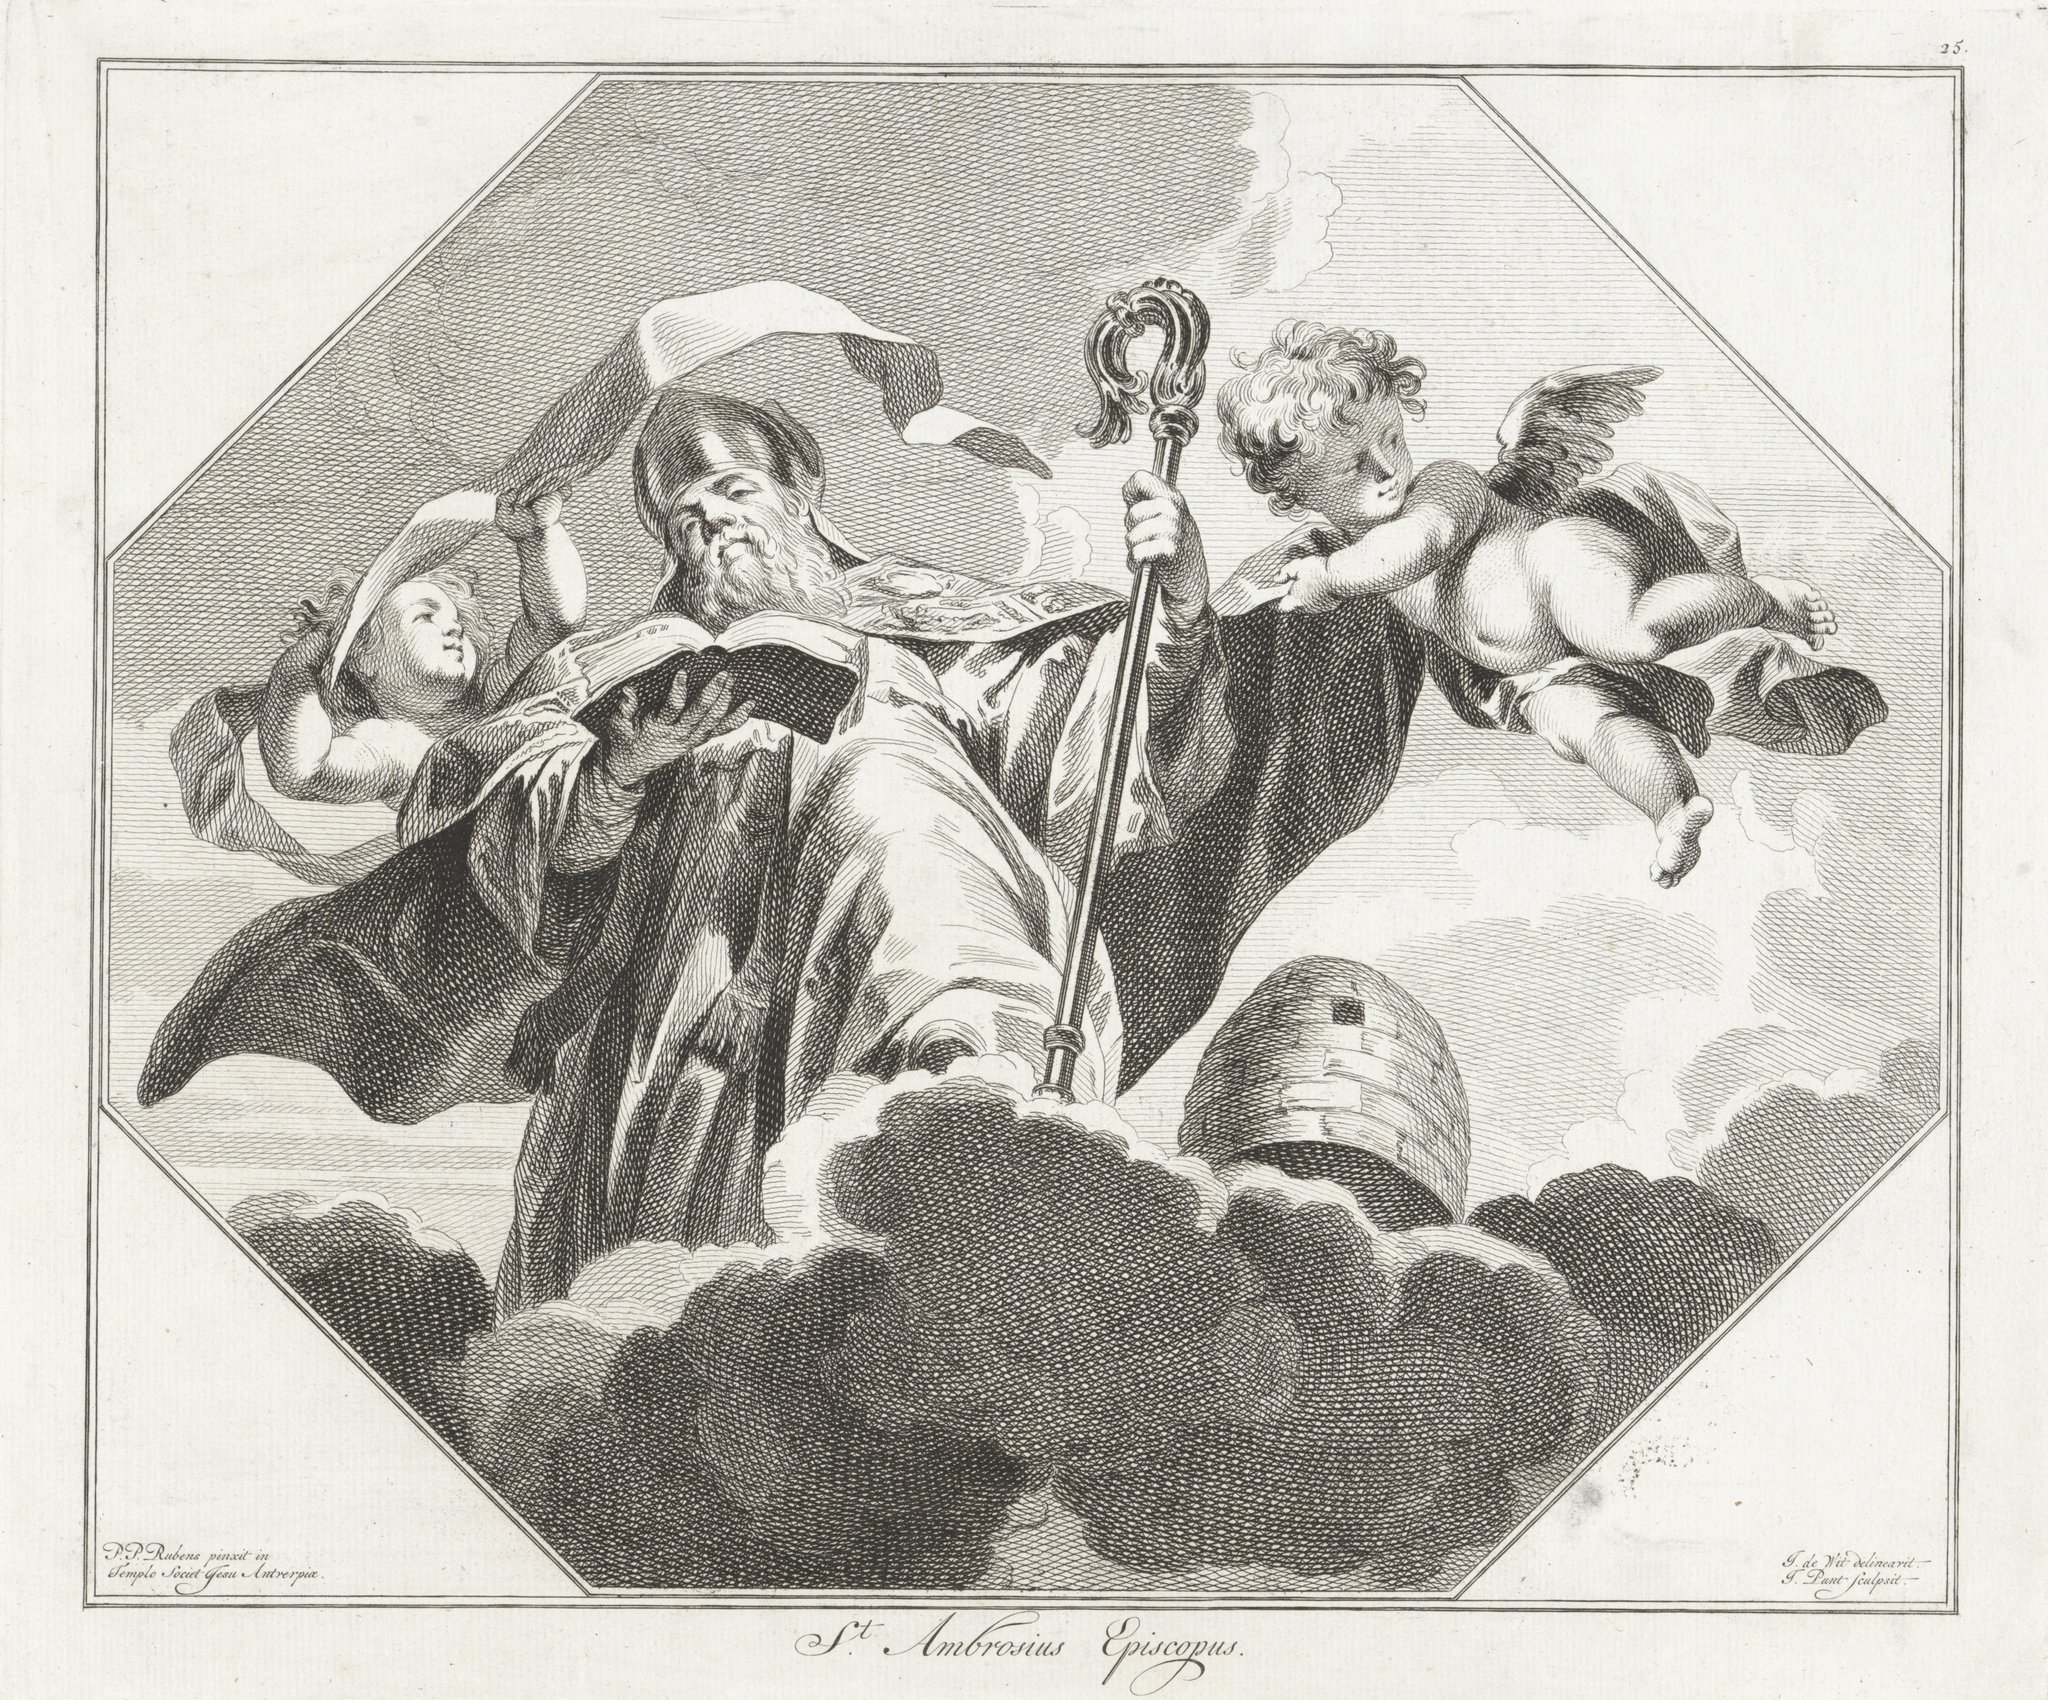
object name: print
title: Les plat-fonds ou les tableaux des galeries / De plafonds of gallerystukken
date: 1721-1779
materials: paper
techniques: engraving, etching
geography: amsterdam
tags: ambrose, bishop of milan; possible attributes: beehive, cradle with baby, three-knotted scourge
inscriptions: collector's mark: Lugt 240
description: Bisschop Ambrosius; onder de octagonale voorstelling een vers.